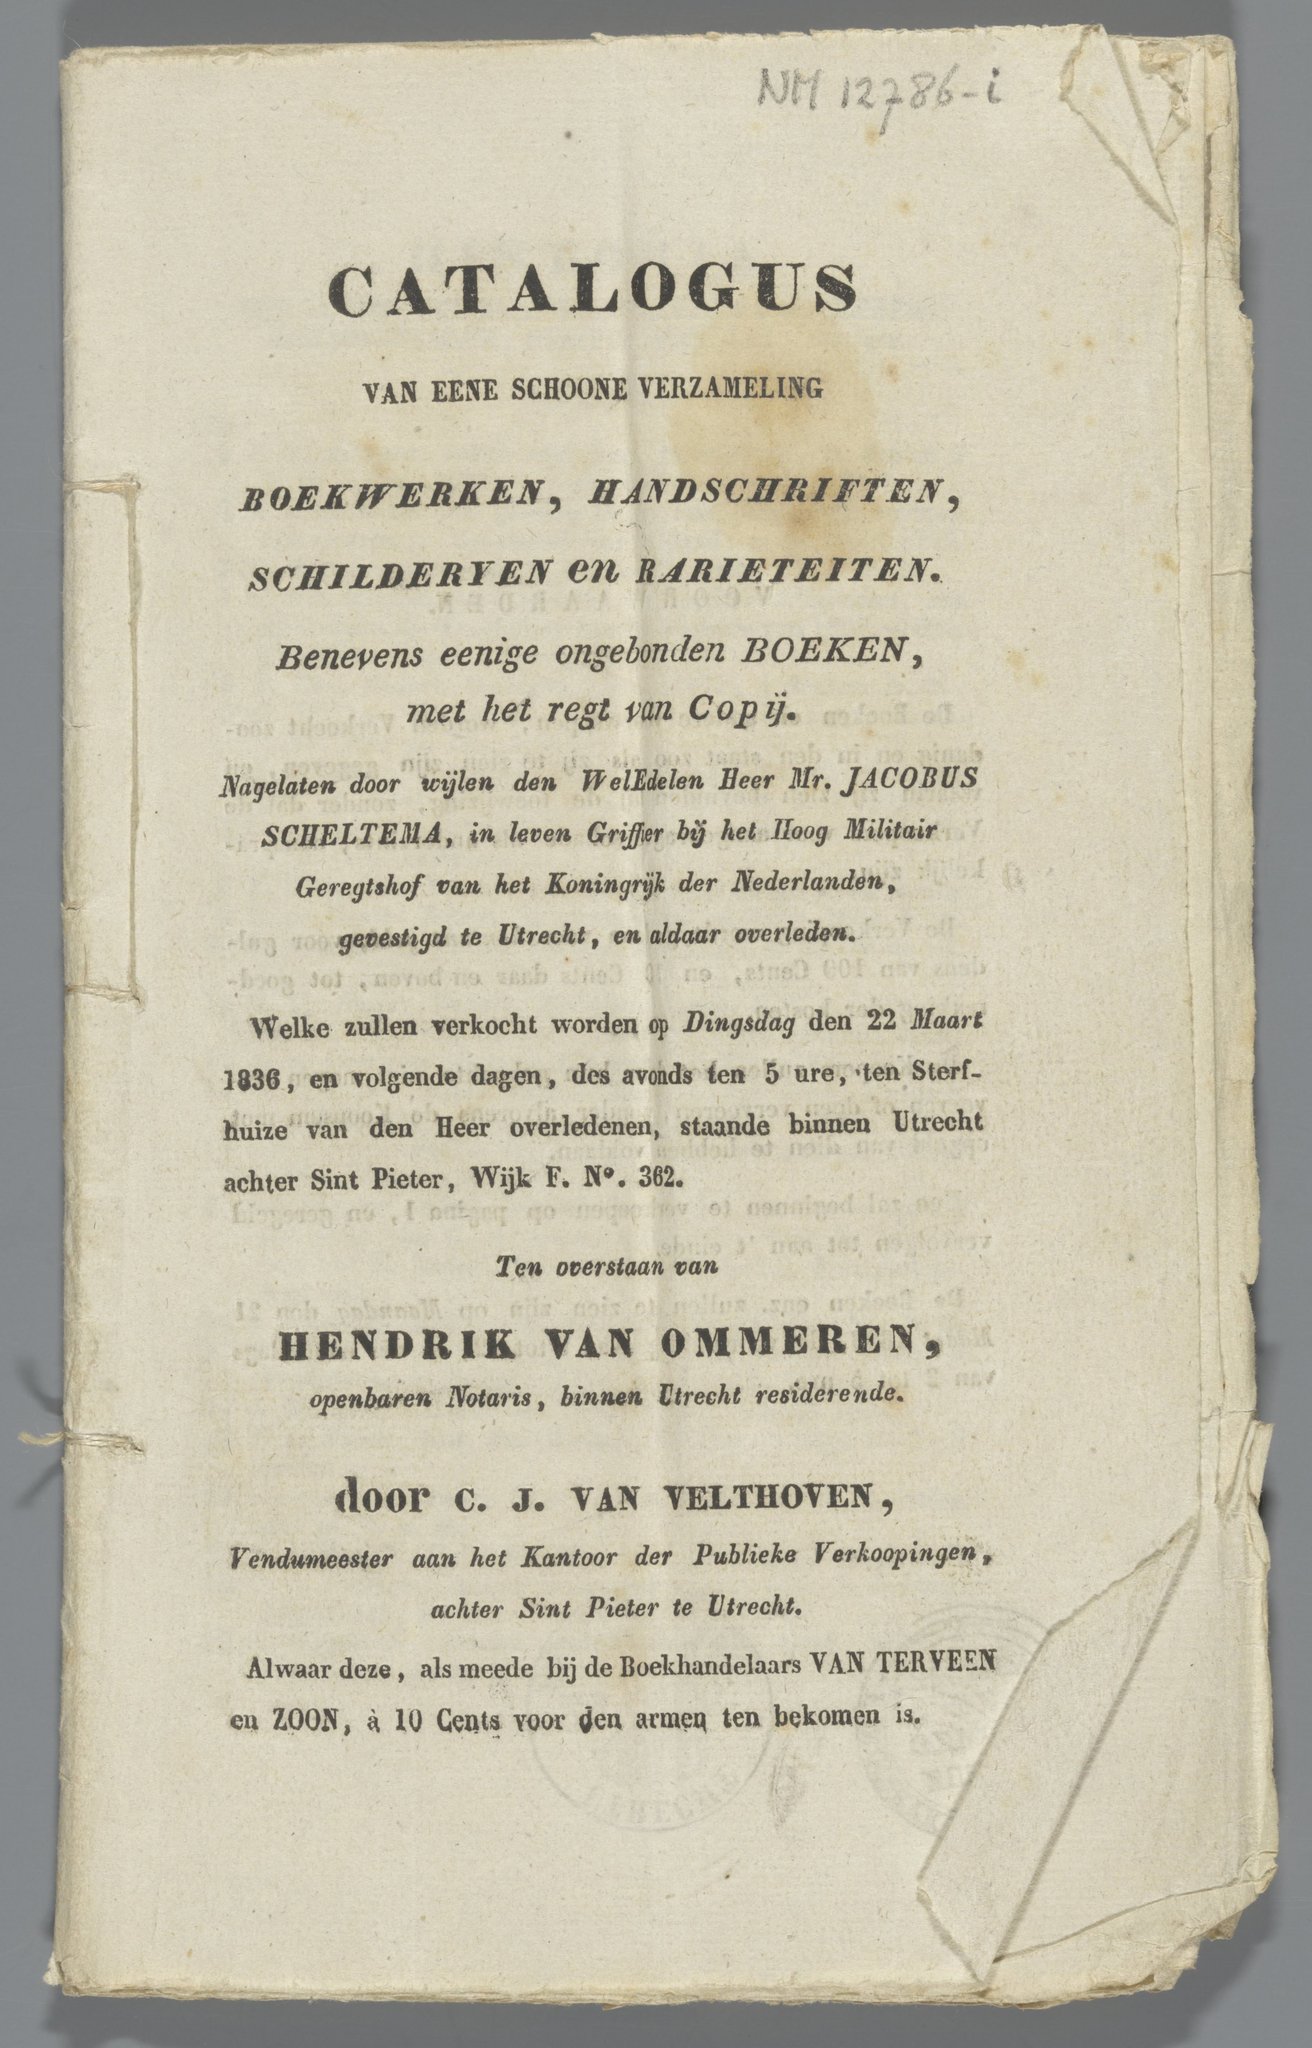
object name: catalog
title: Veilingcatalogus van eene schone verzameling boekwerken etc. nagelaten door wijlen den Wel Edelen Heer Mr. Jacobus Scheltema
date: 1836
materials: paper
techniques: bookbinding, printing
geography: utrecht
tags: peter i de grote (tsaar van rusland)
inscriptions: date